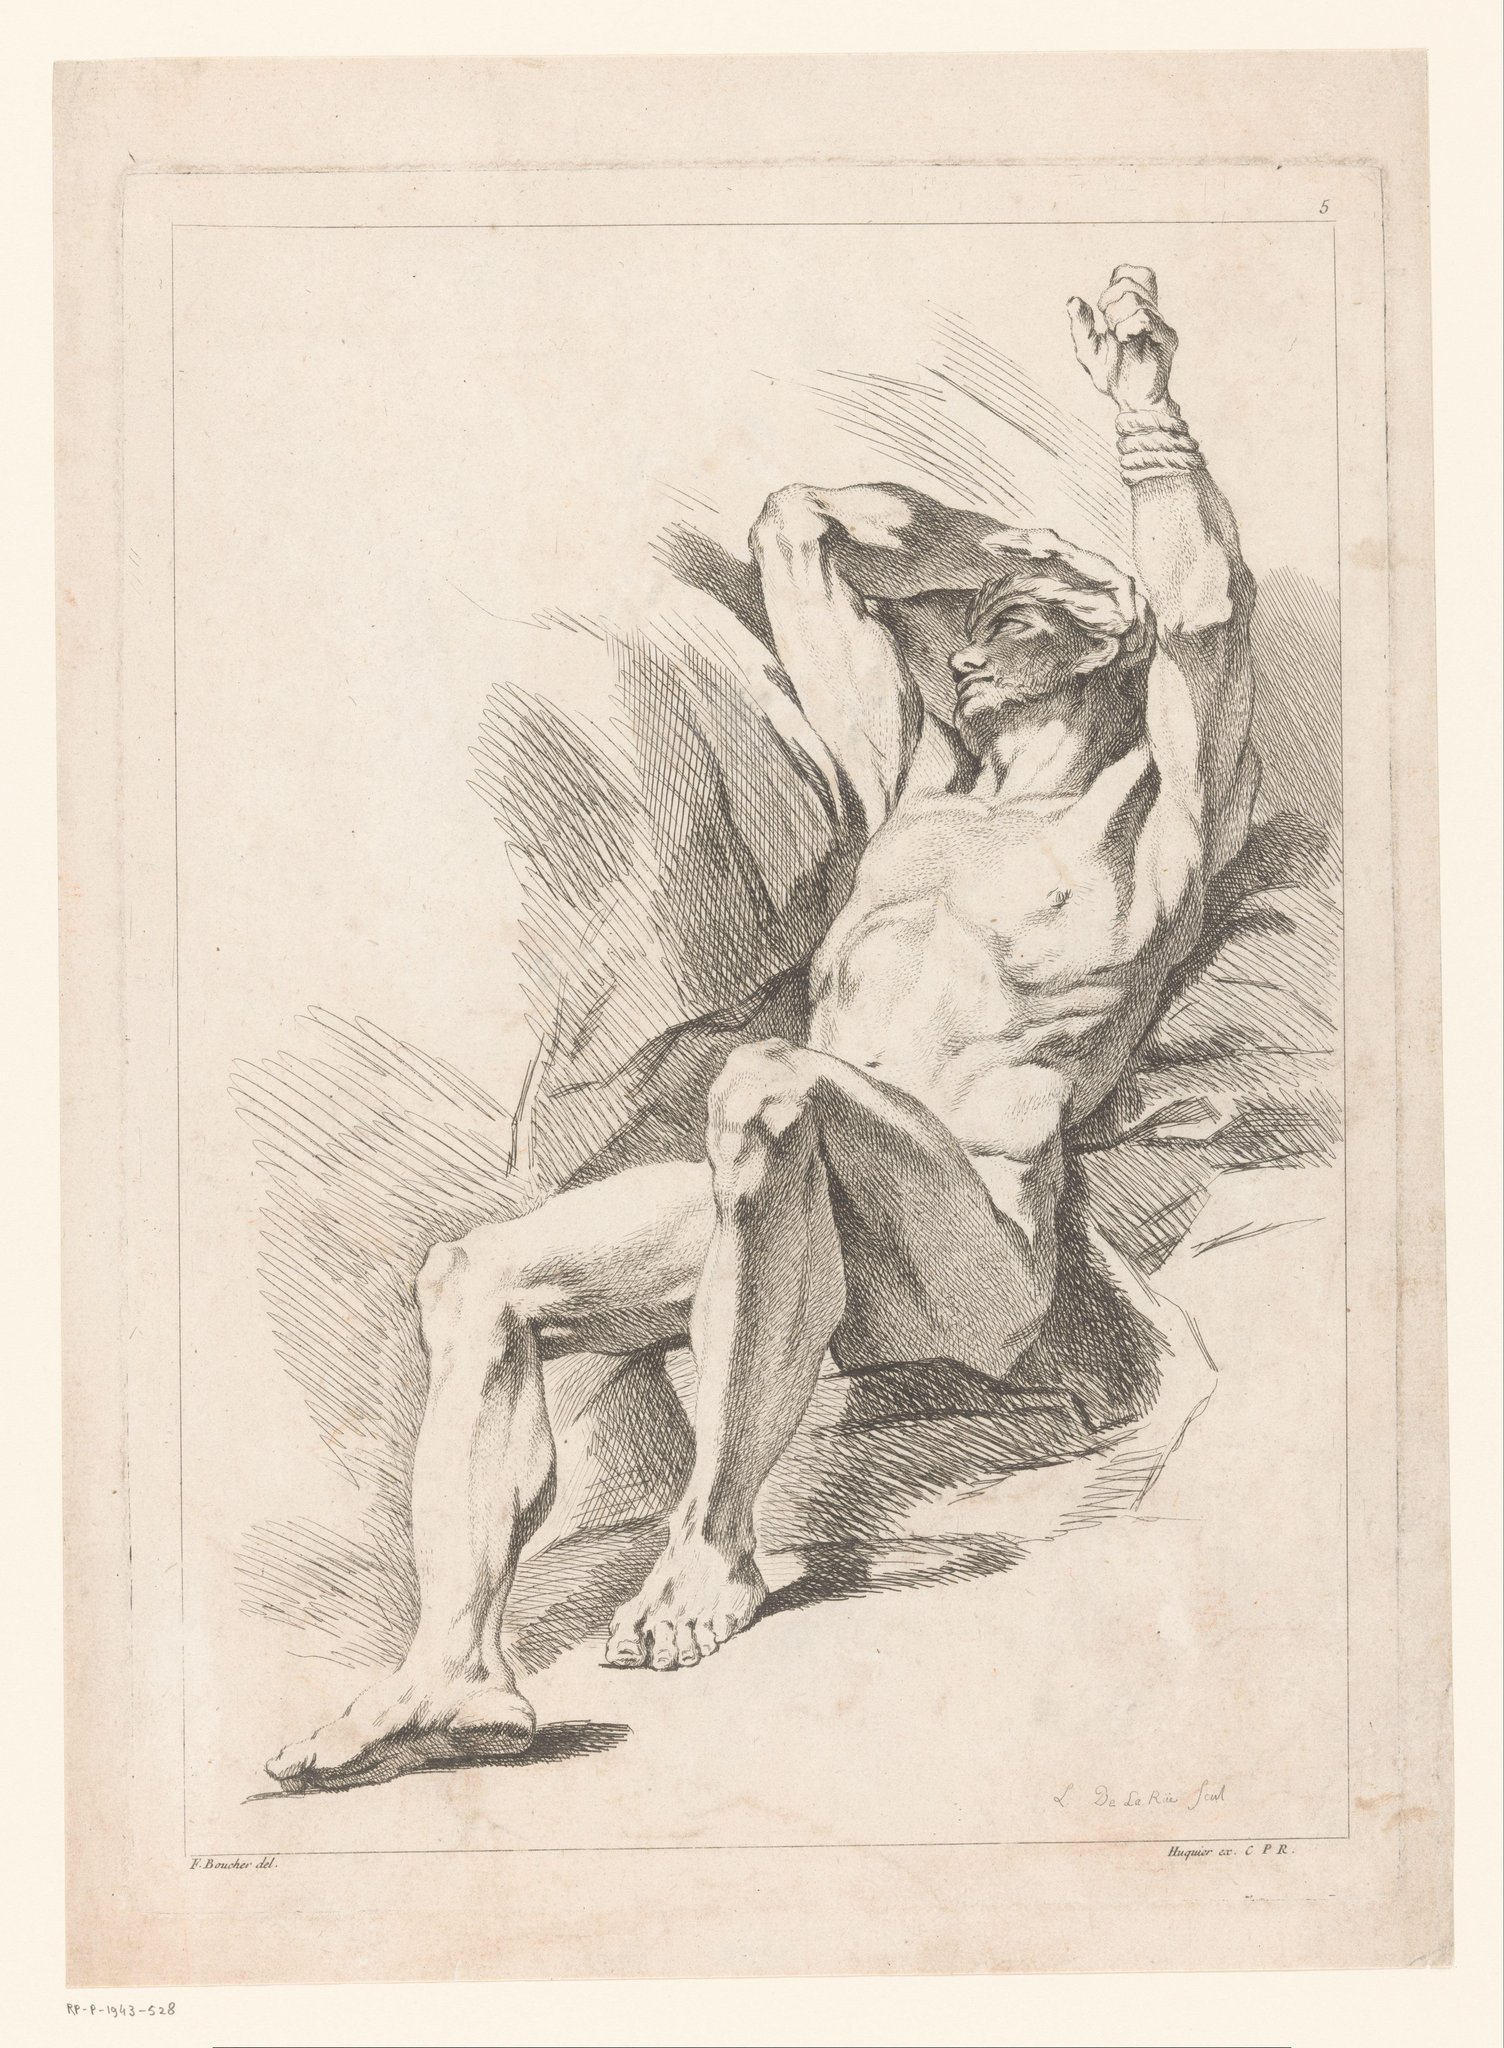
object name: print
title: Liggend mannelijk naakt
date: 1741-1765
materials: paper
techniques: etching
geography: france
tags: the (nude) human figure; 'corpo humano' (ripa)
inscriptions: collector's mark: Lugt 2228